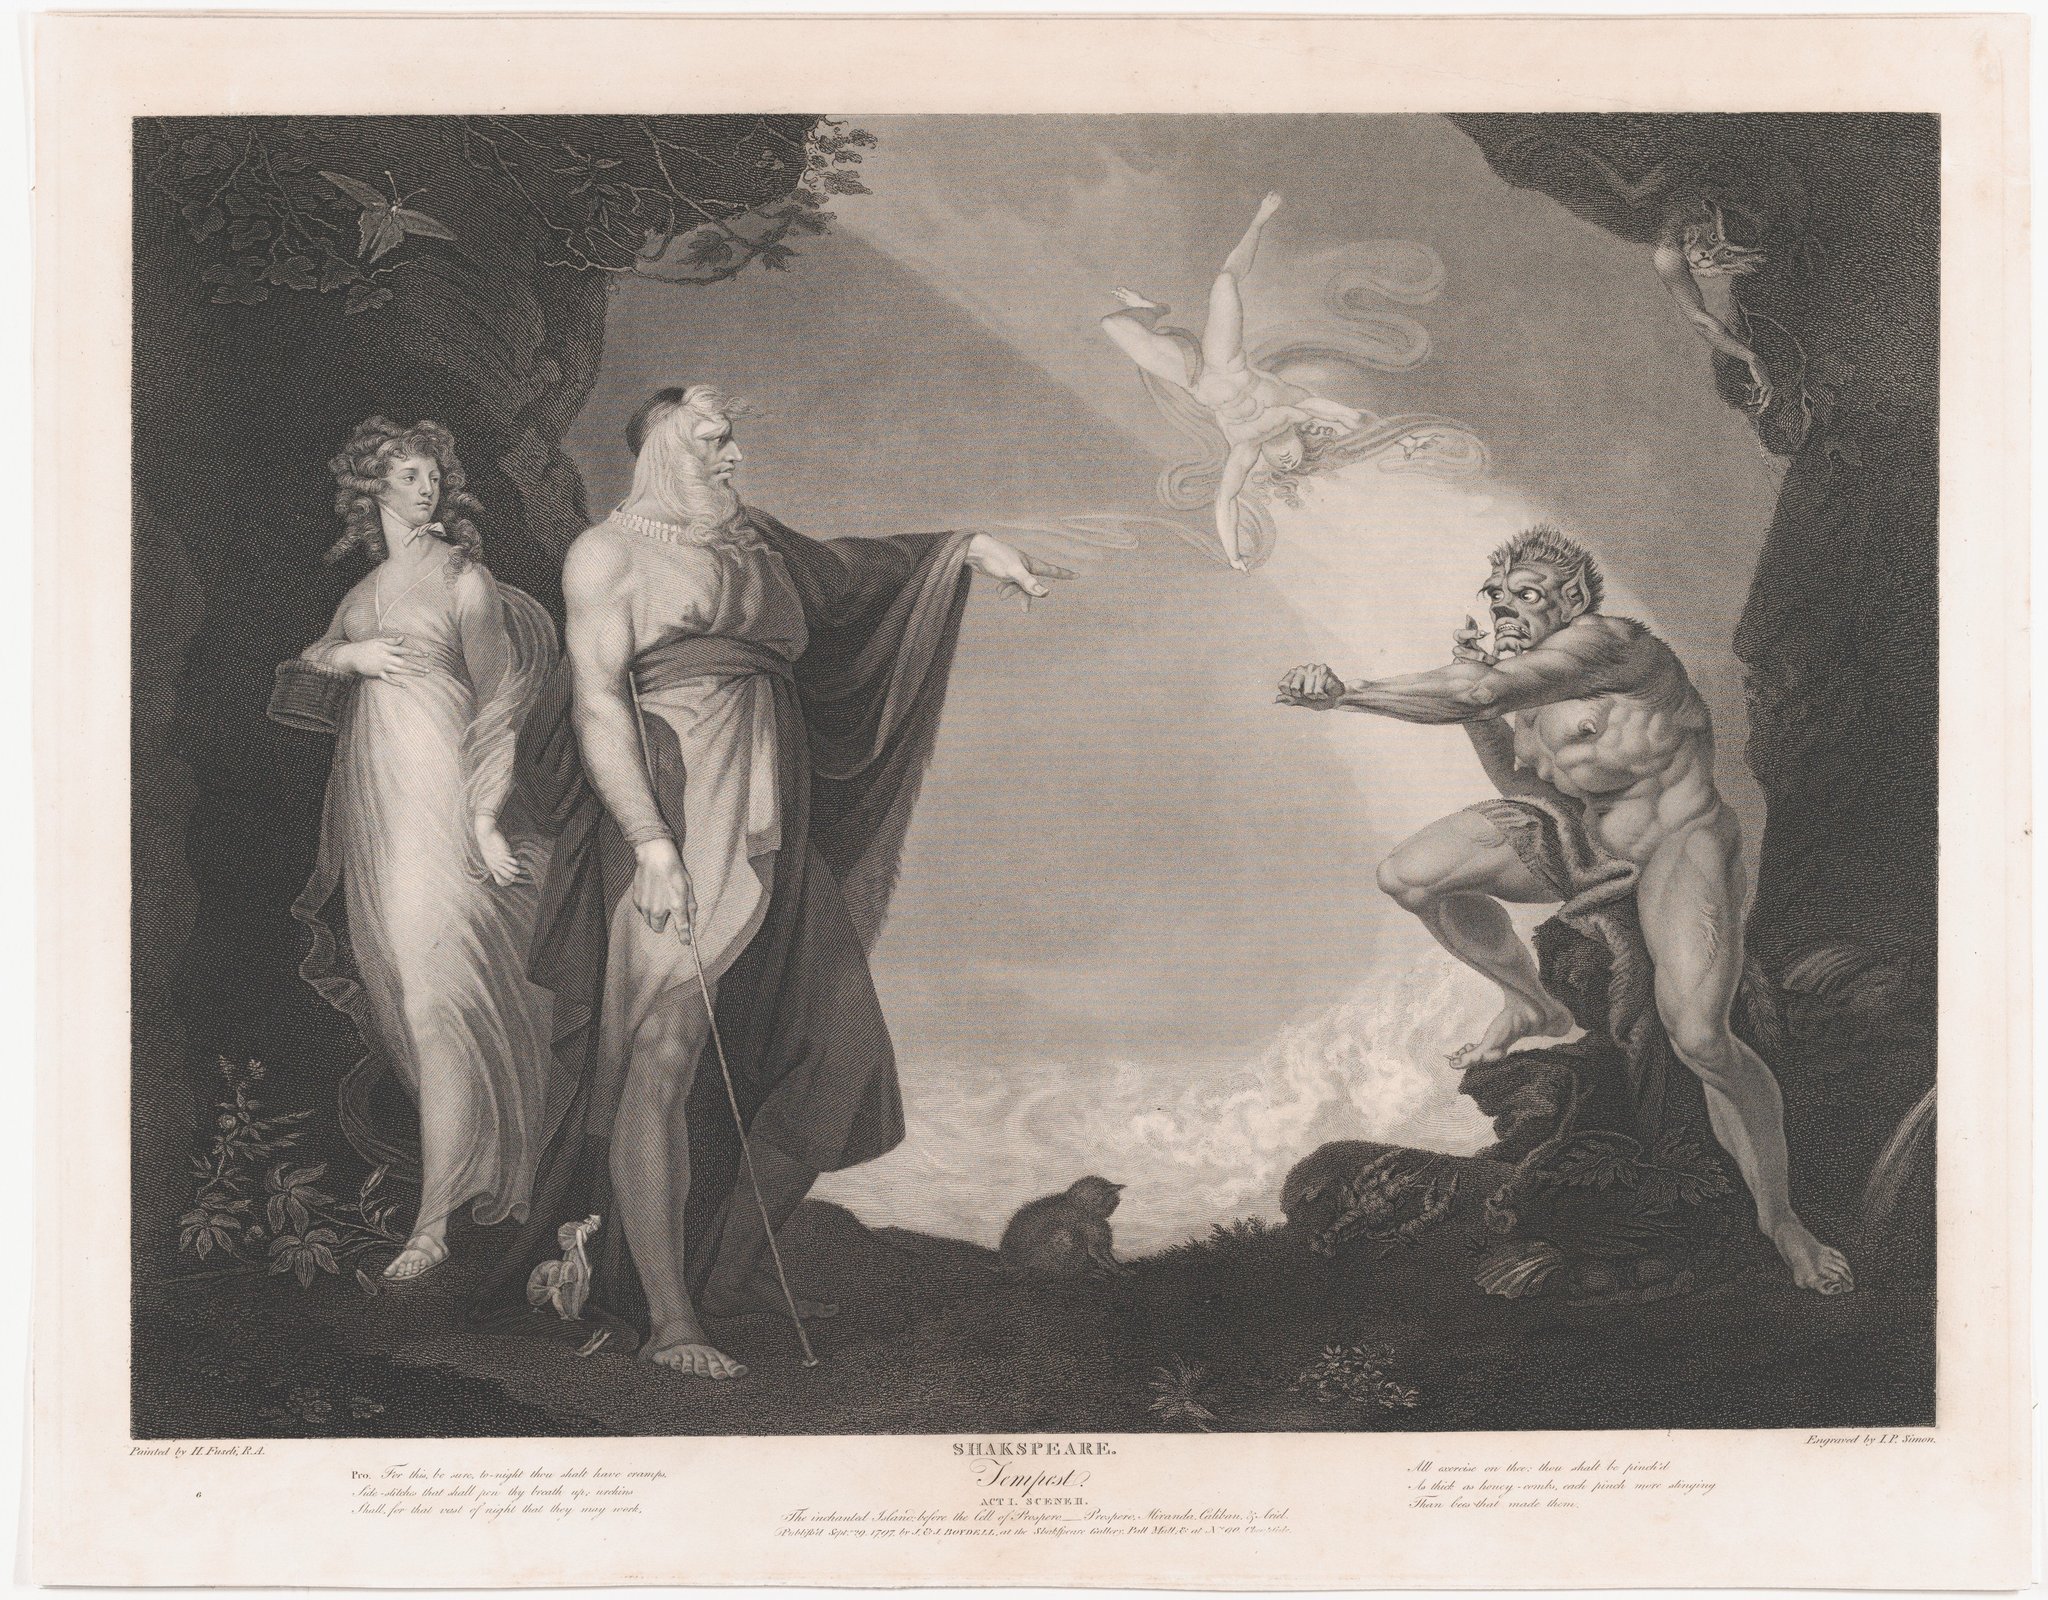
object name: print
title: The Enchanted Island Before the Cell of Prospero - Prospero, Miranda, Caliban and Ariel (Shakespeare, The Tempest, Act 1, Scene 2)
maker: peter simon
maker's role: engraver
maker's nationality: british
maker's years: 1764-1813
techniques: engraving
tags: shakespeare,men,women,cats,monkeys